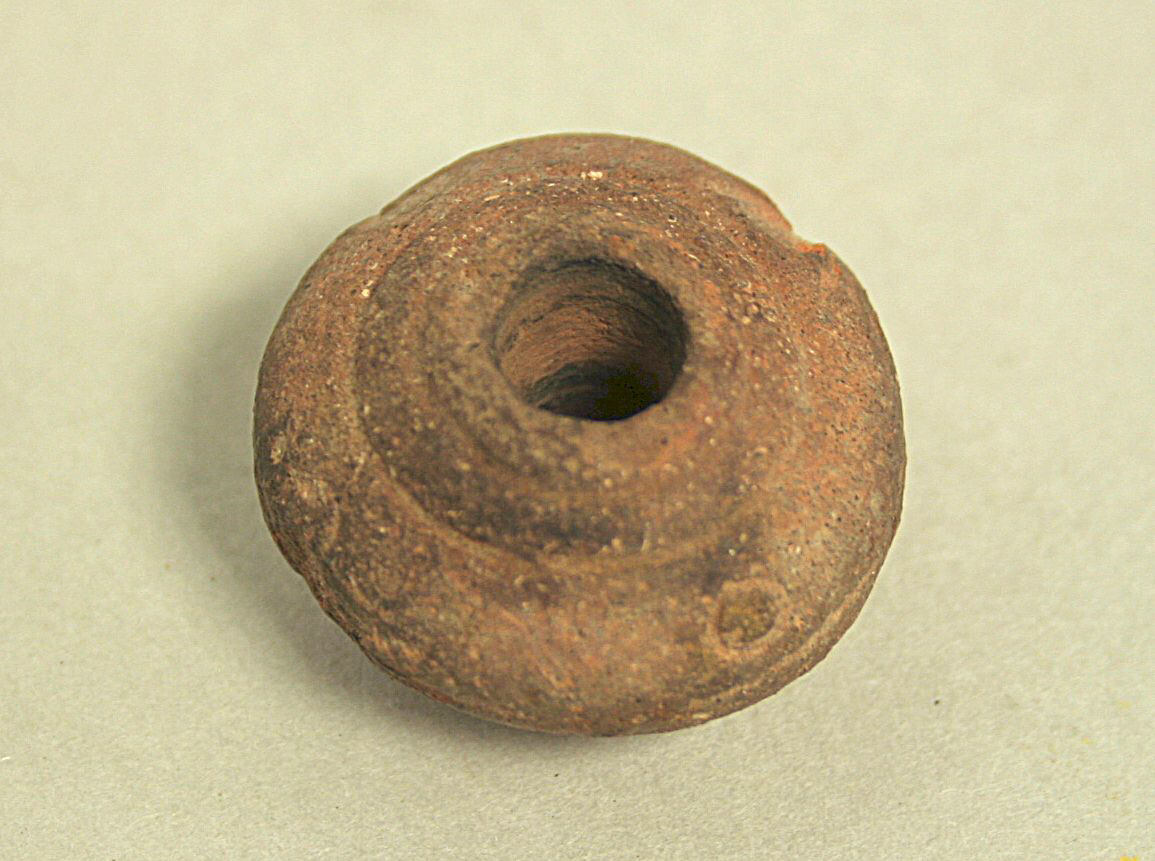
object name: spindle whorl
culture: peruvian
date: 1-500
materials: ceramic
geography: peru